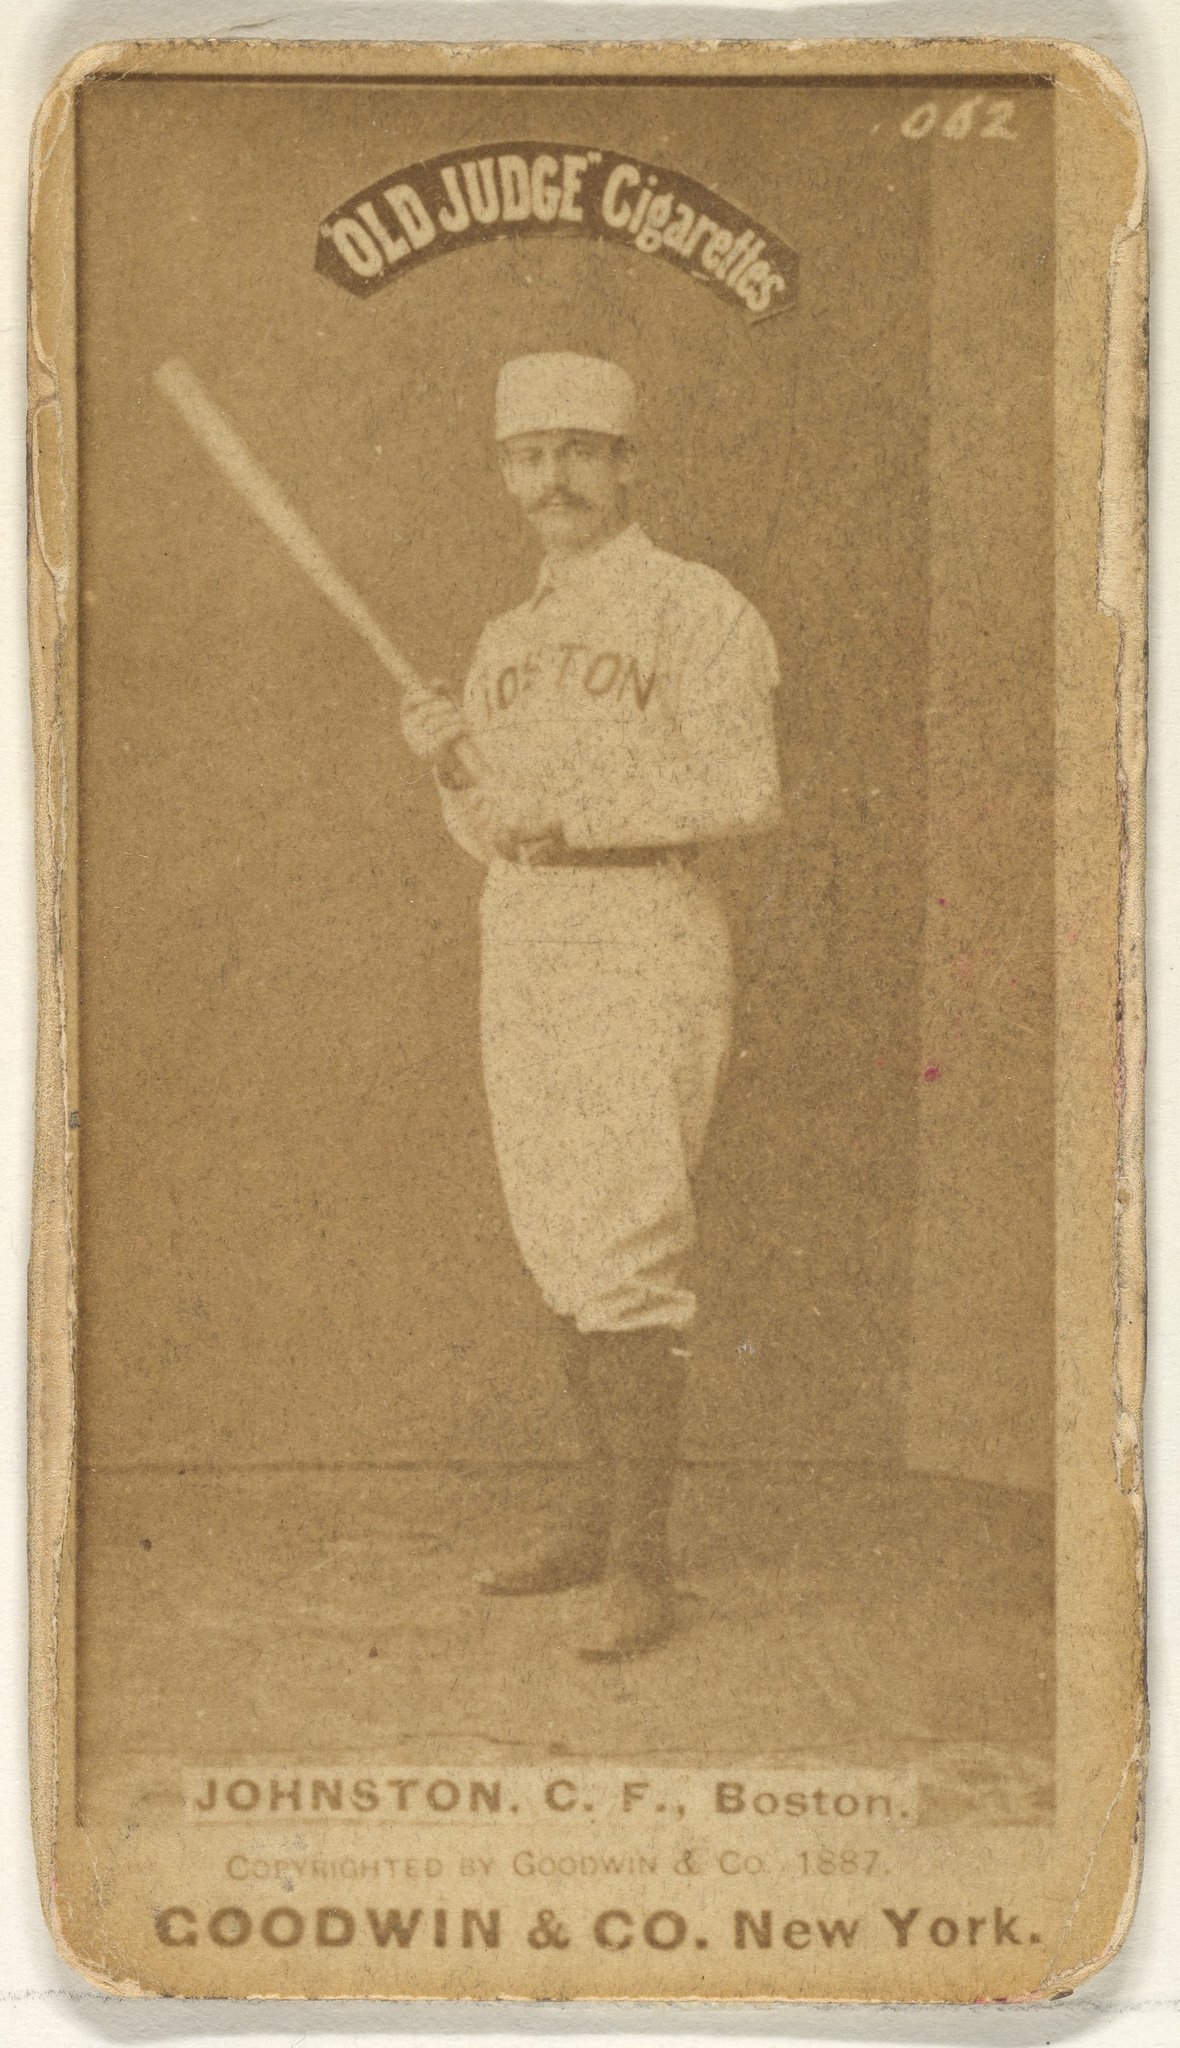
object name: baseball card, photograph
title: Johnston, Center Field, Boston, from the Old Judge series (N172) for Old Judge Cigarettes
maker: goodwin & company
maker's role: publisher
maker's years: 1850-1950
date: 1887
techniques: albumen silver print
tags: men,portraits,baseball,athletes